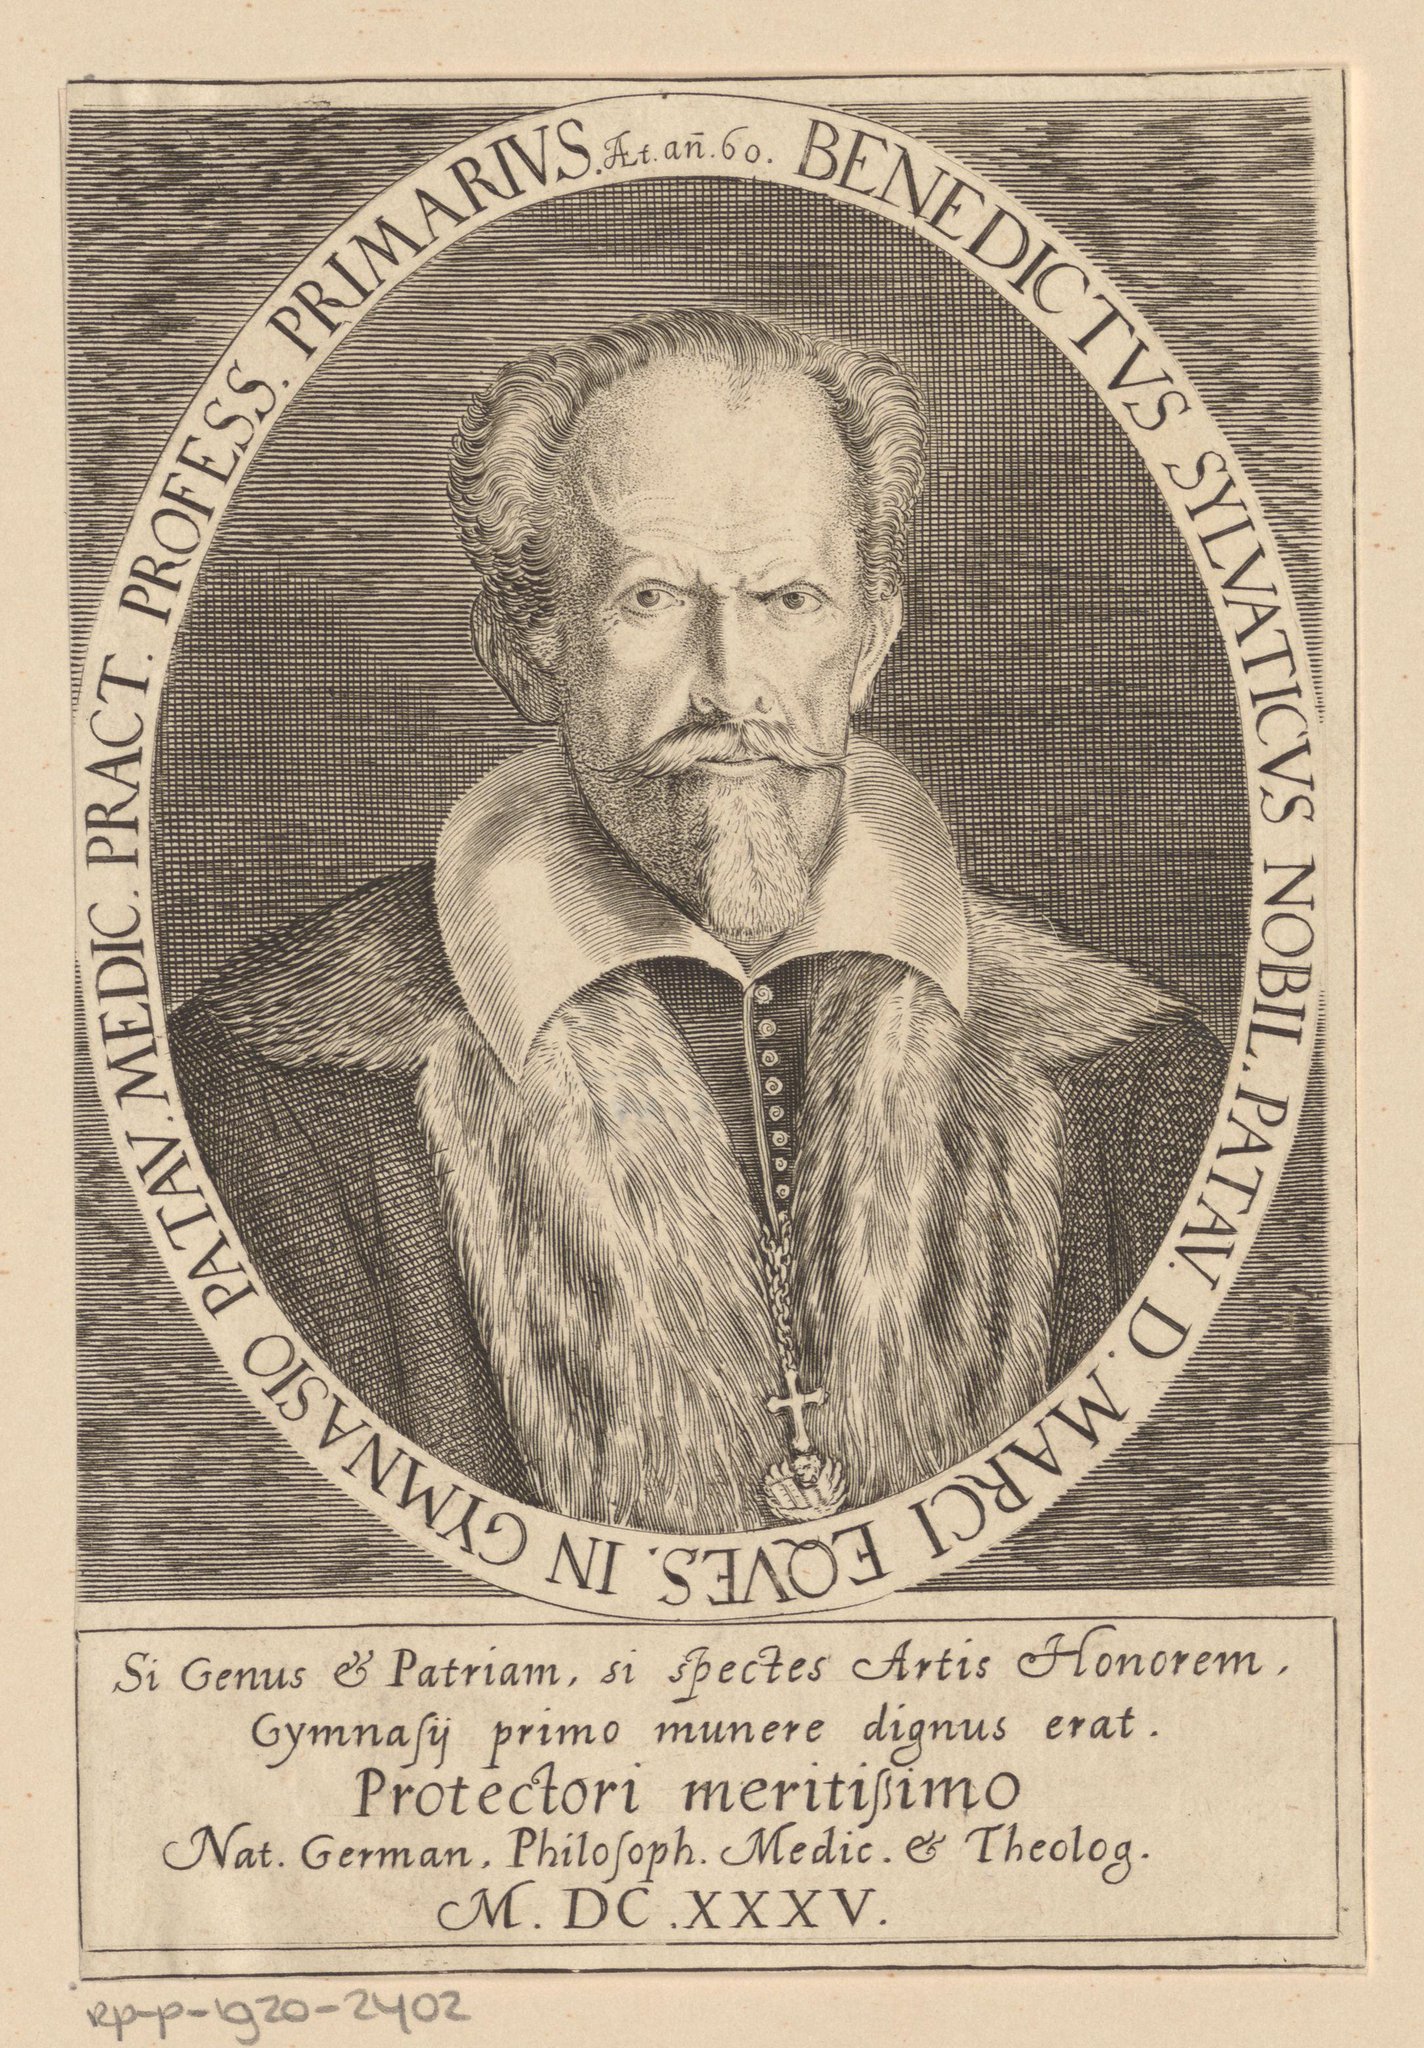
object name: print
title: Portret van Benedetto Selvatico op 60-jarige leeftijd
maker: Anonymous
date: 1635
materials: paper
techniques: engraving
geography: germany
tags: historical persons, physician, doctor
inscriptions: collector's mark: Lugt 2228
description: Met vijfregelig onderschrift in het Latijn.